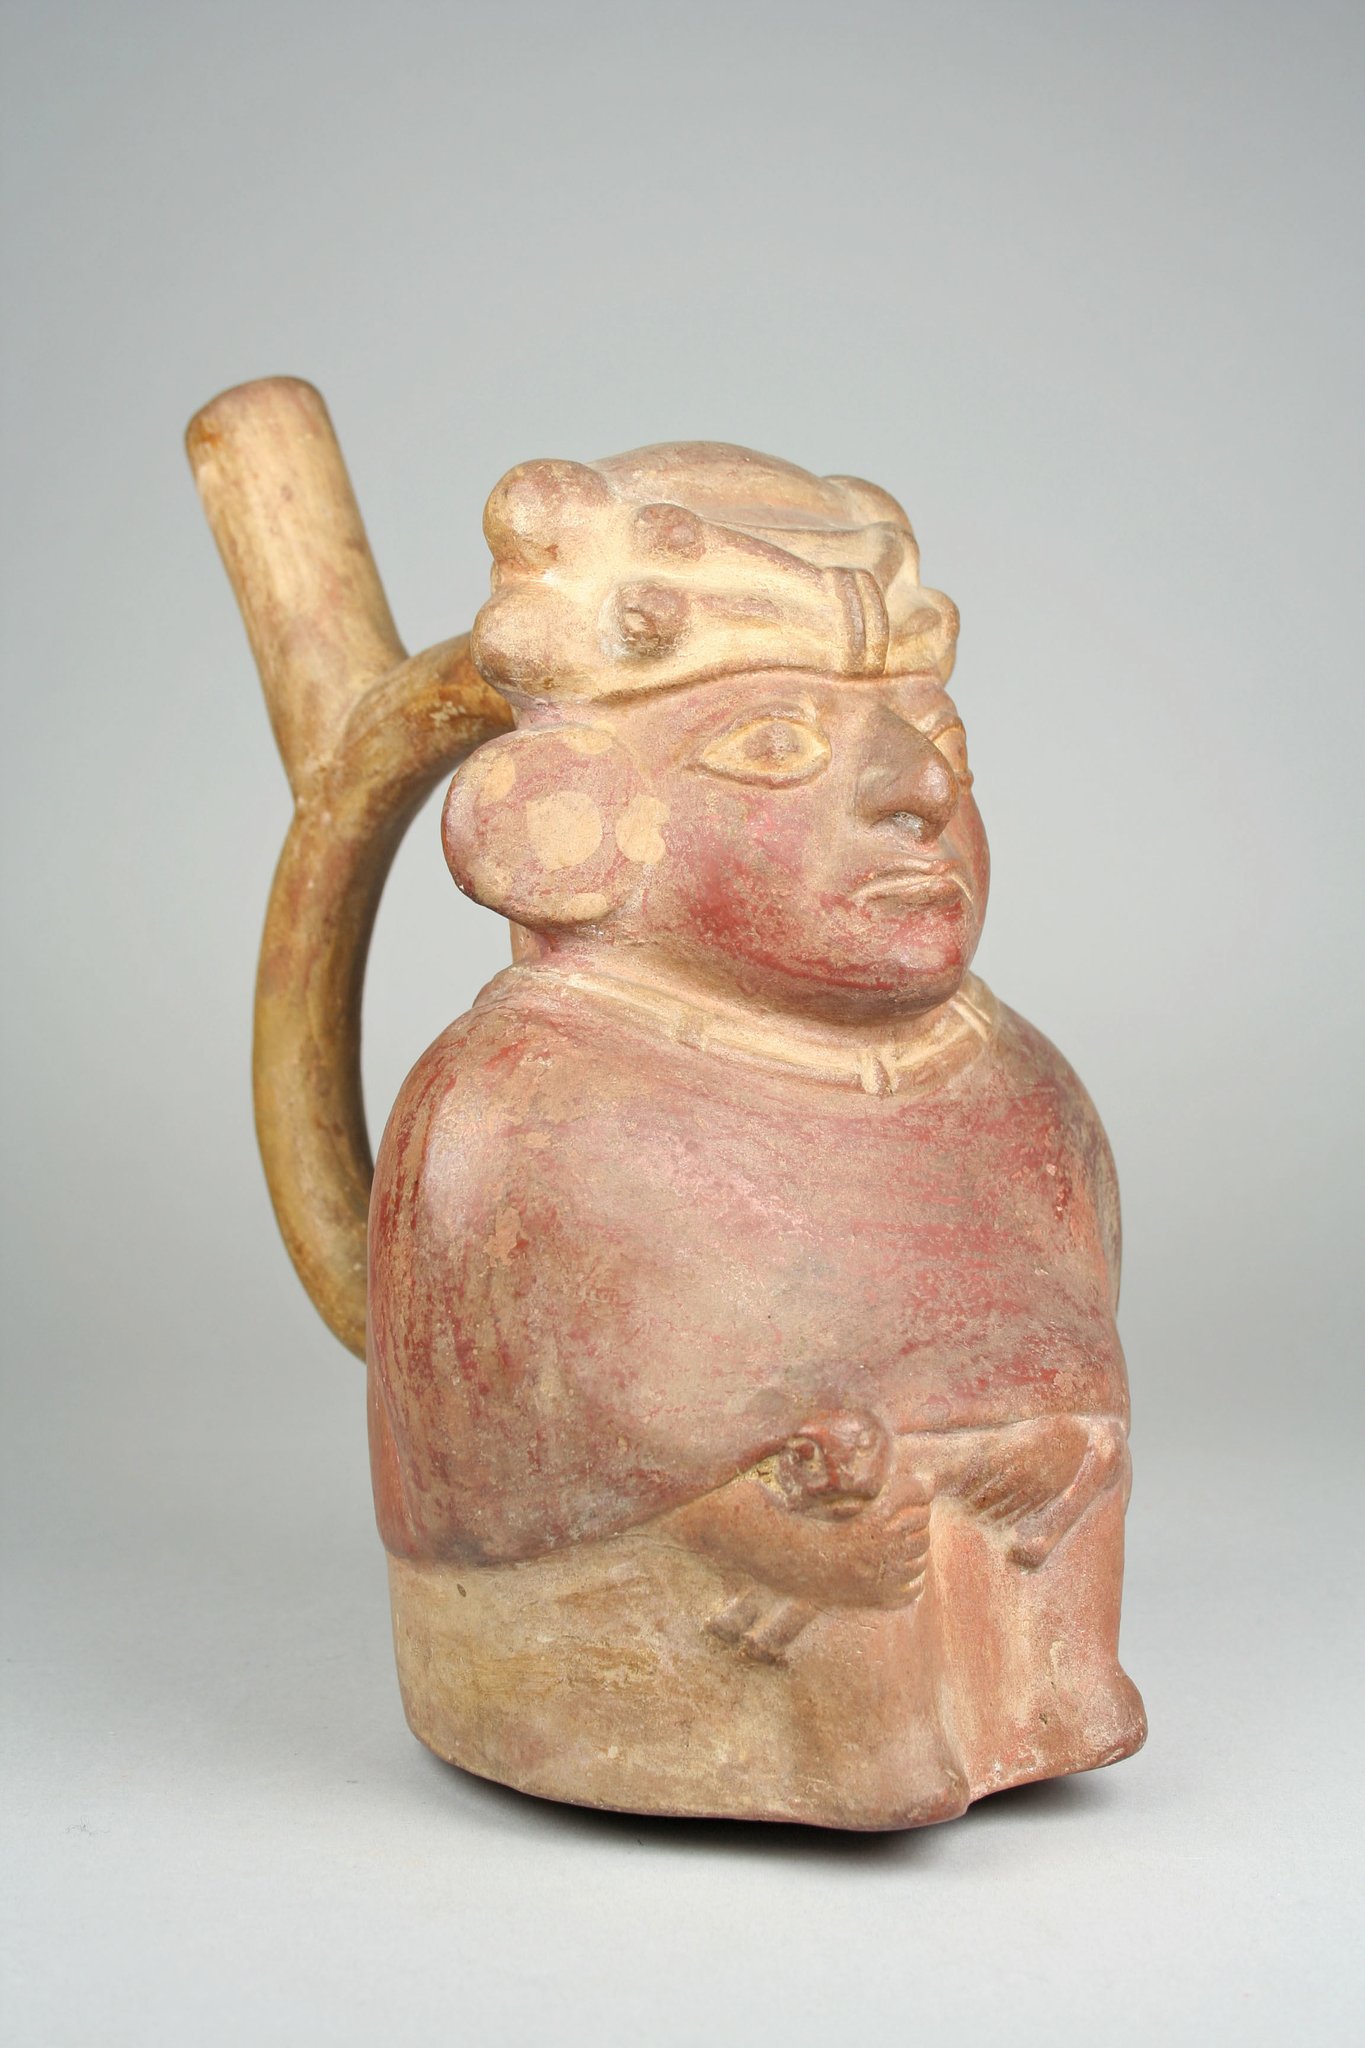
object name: vessel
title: Vessel, Dignitary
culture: moche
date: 100 BCE-700 CE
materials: ceramic, pigment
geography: peru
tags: men